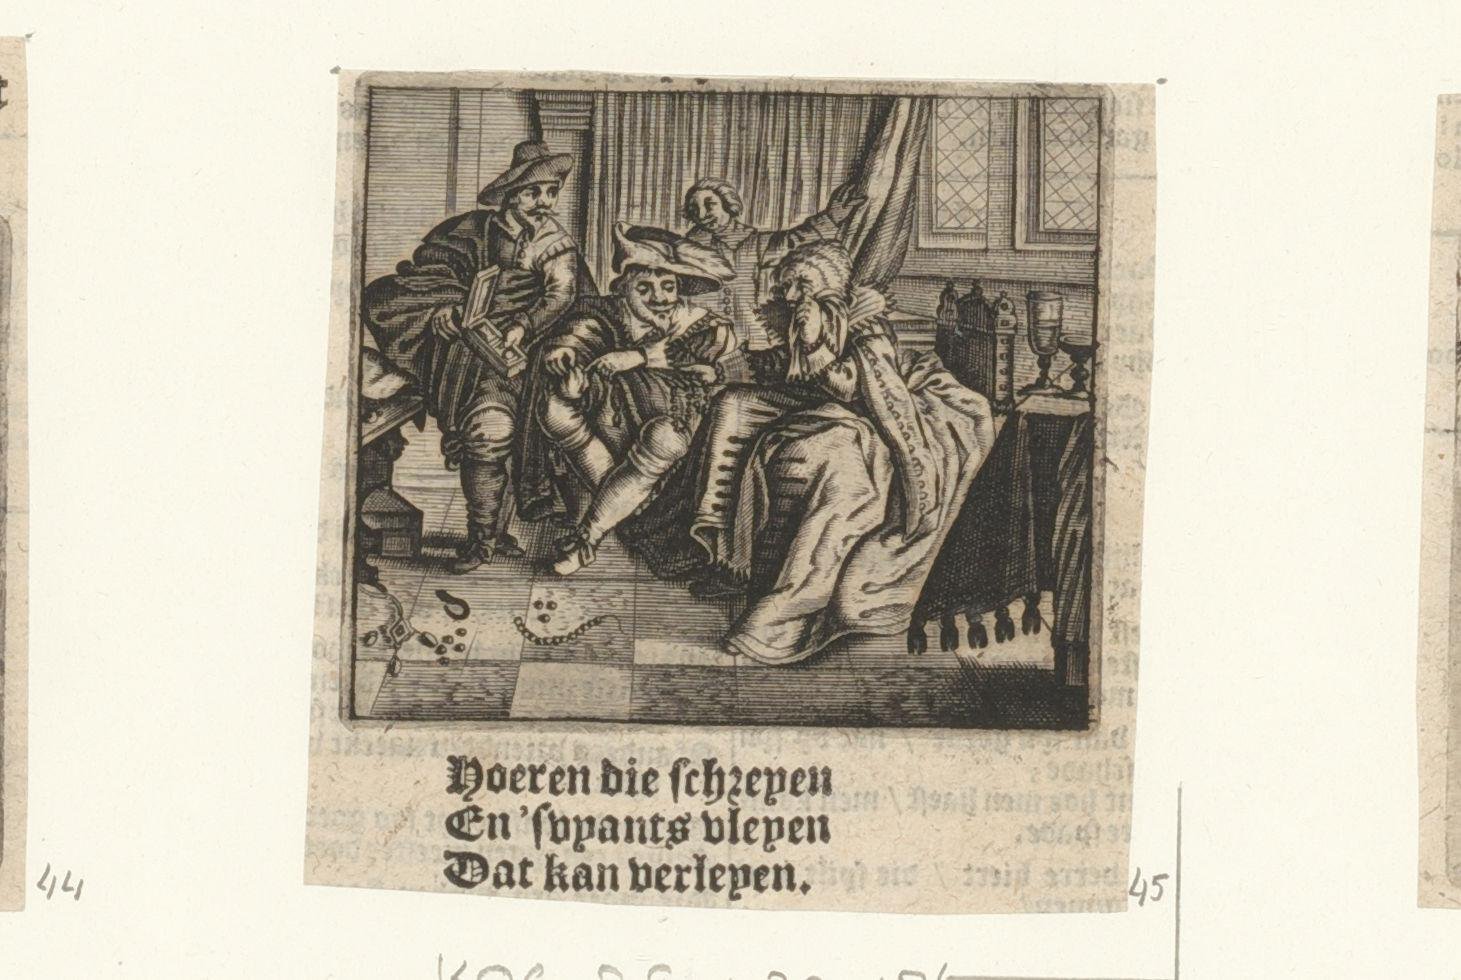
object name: book illustration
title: Hoeren die schreyen, en 's vyants vleyen, dat kan verleyen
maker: Anonymous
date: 1635-1715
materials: paper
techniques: engraving, letterpress printing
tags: adult woman, adult man, ornaments, jewels, proverbs, sayings, etc., weeping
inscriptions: collector's mark: Lugt 1641, stamp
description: Veel versies van dit embleem verschenen in verschillende uitgave van Spiegel van den Ouden ende Nieuwen Tydt. Zoals: Cats, Jacob. Spiegel van den Ouden ende Nieuwen-tijt, Bestaende uyt Spreeck-woorden (...). Dordrecht: Jacob Braat, 1647. Maar ook in andere publicaties (1665, 1671, 1715, 1722).